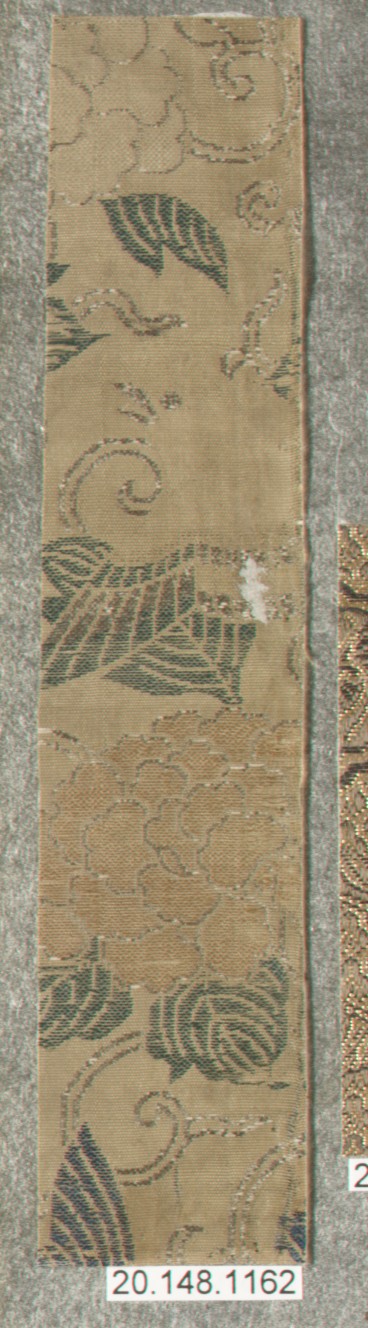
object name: piece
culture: japanese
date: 1801-1900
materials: silk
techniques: compound weave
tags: leaves